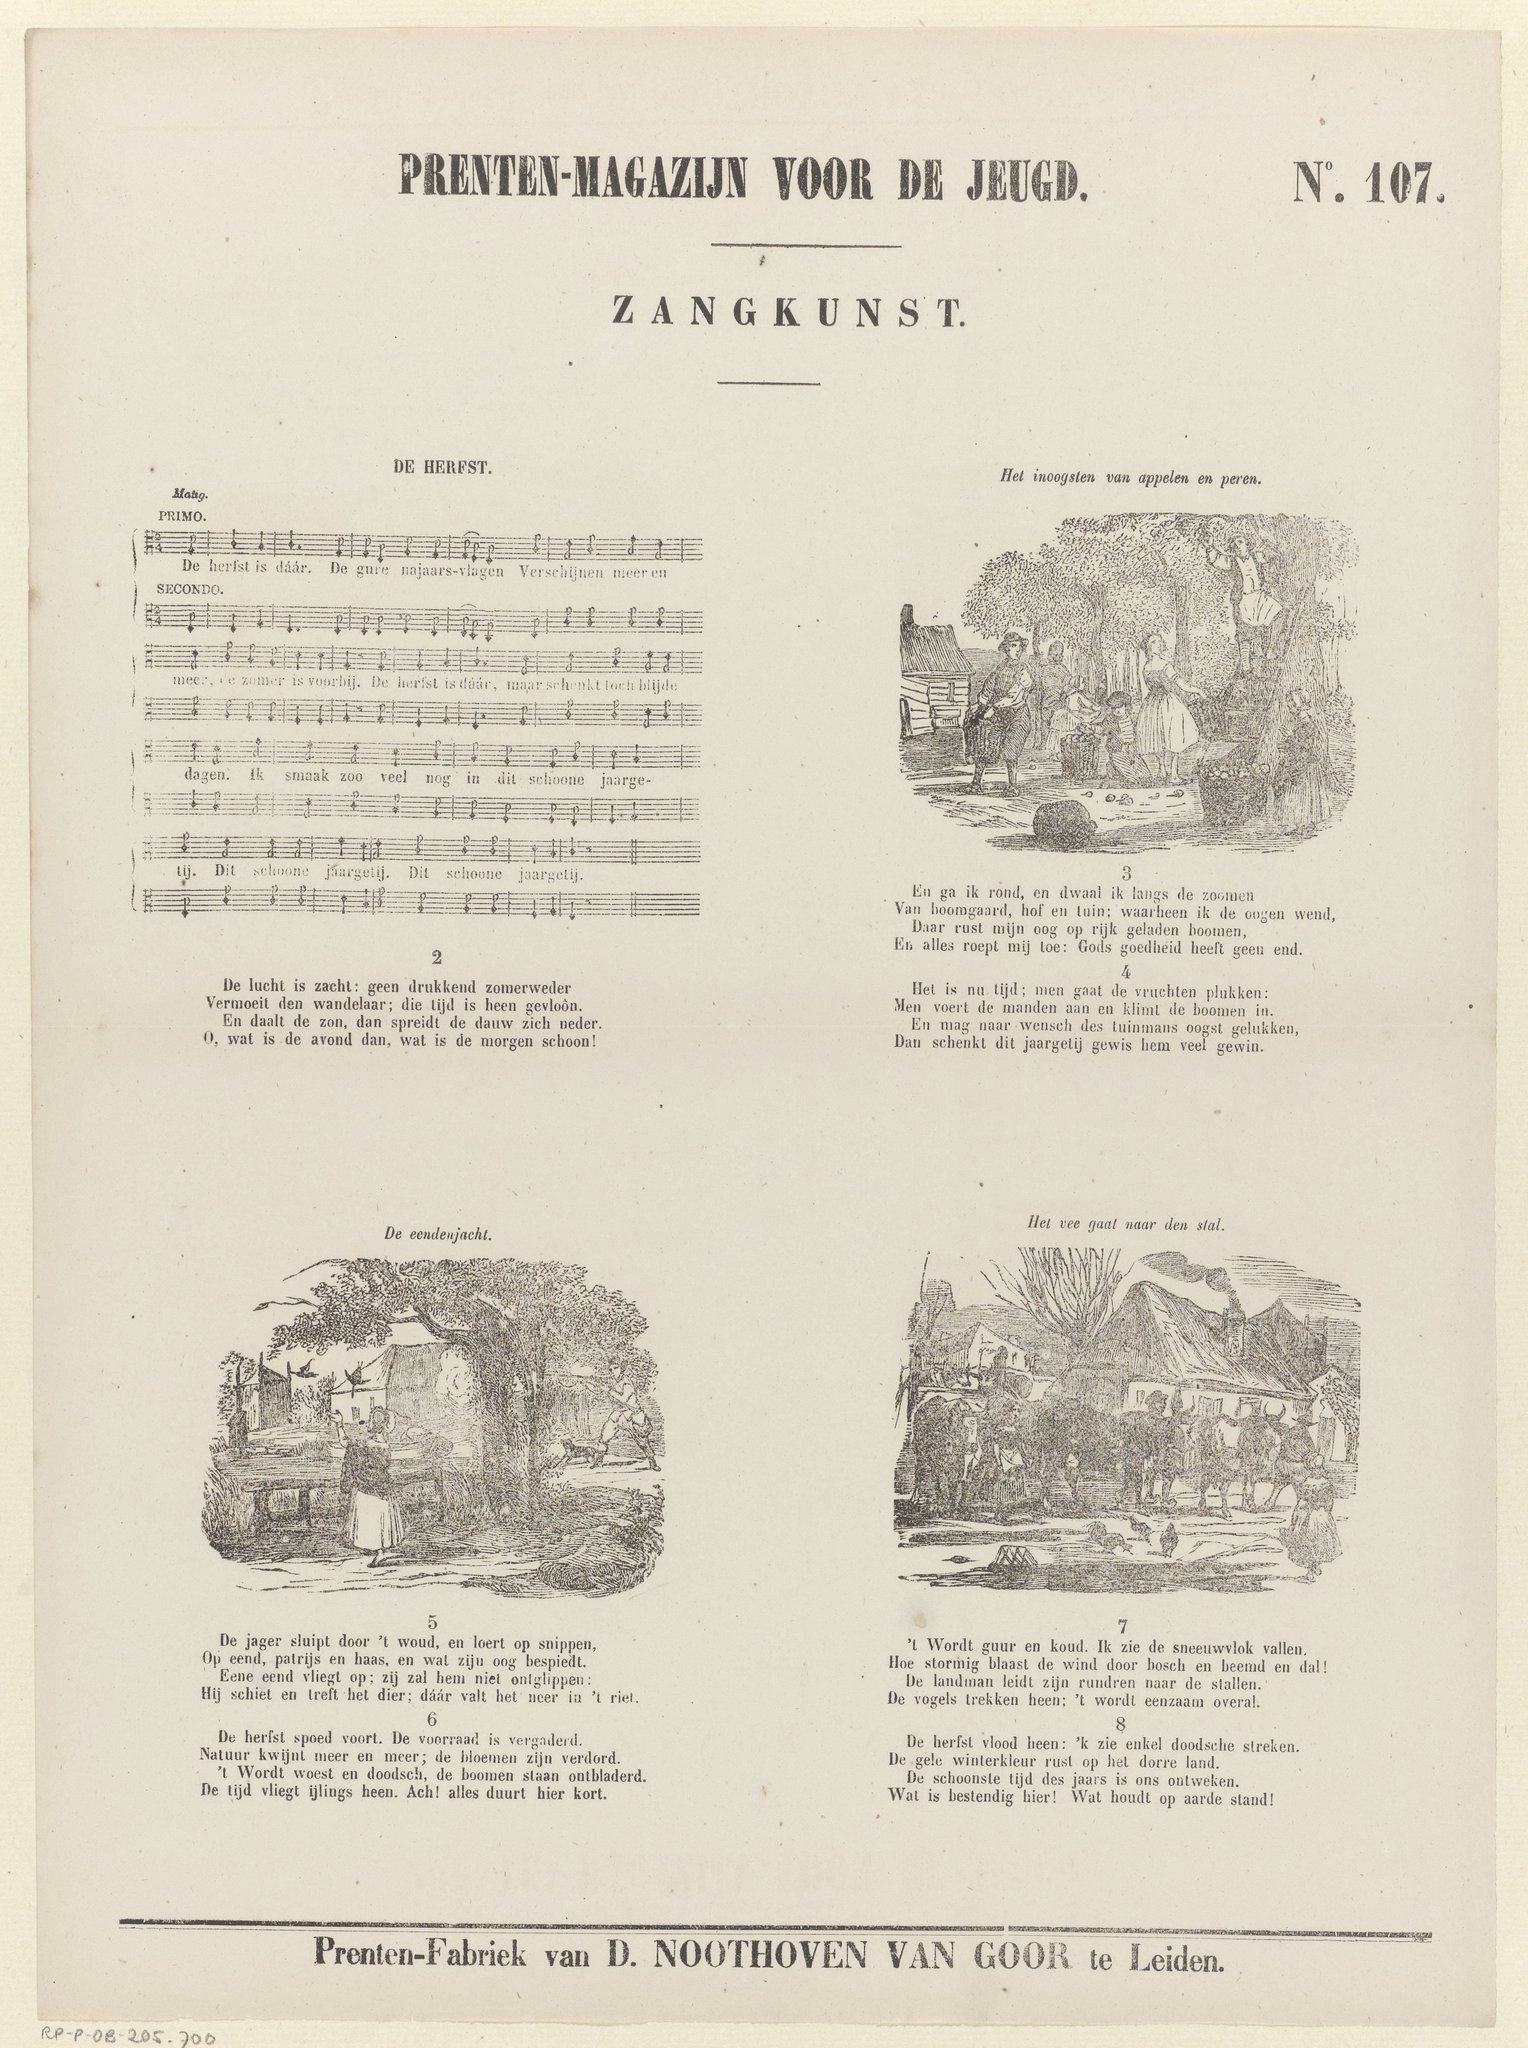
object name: print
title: Prenten-magazijn voor de jeugd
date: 1850-1881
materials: paper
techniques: letterpress printing, engraving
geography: leiden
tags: seasons of the year represented by scenes showing human activities, usually in a landscape, autumn ~ human activities (the four seasons of the year)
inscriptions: collector's mark: Lugt 2760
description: Blad met 3 voorstellingen en een stuk bladmuziek met een lied over de herfst. Boven elke voorstelling een titel en onder elke voorstelling coupletten van het lied. Genummerd rechtsboven: No. 107.